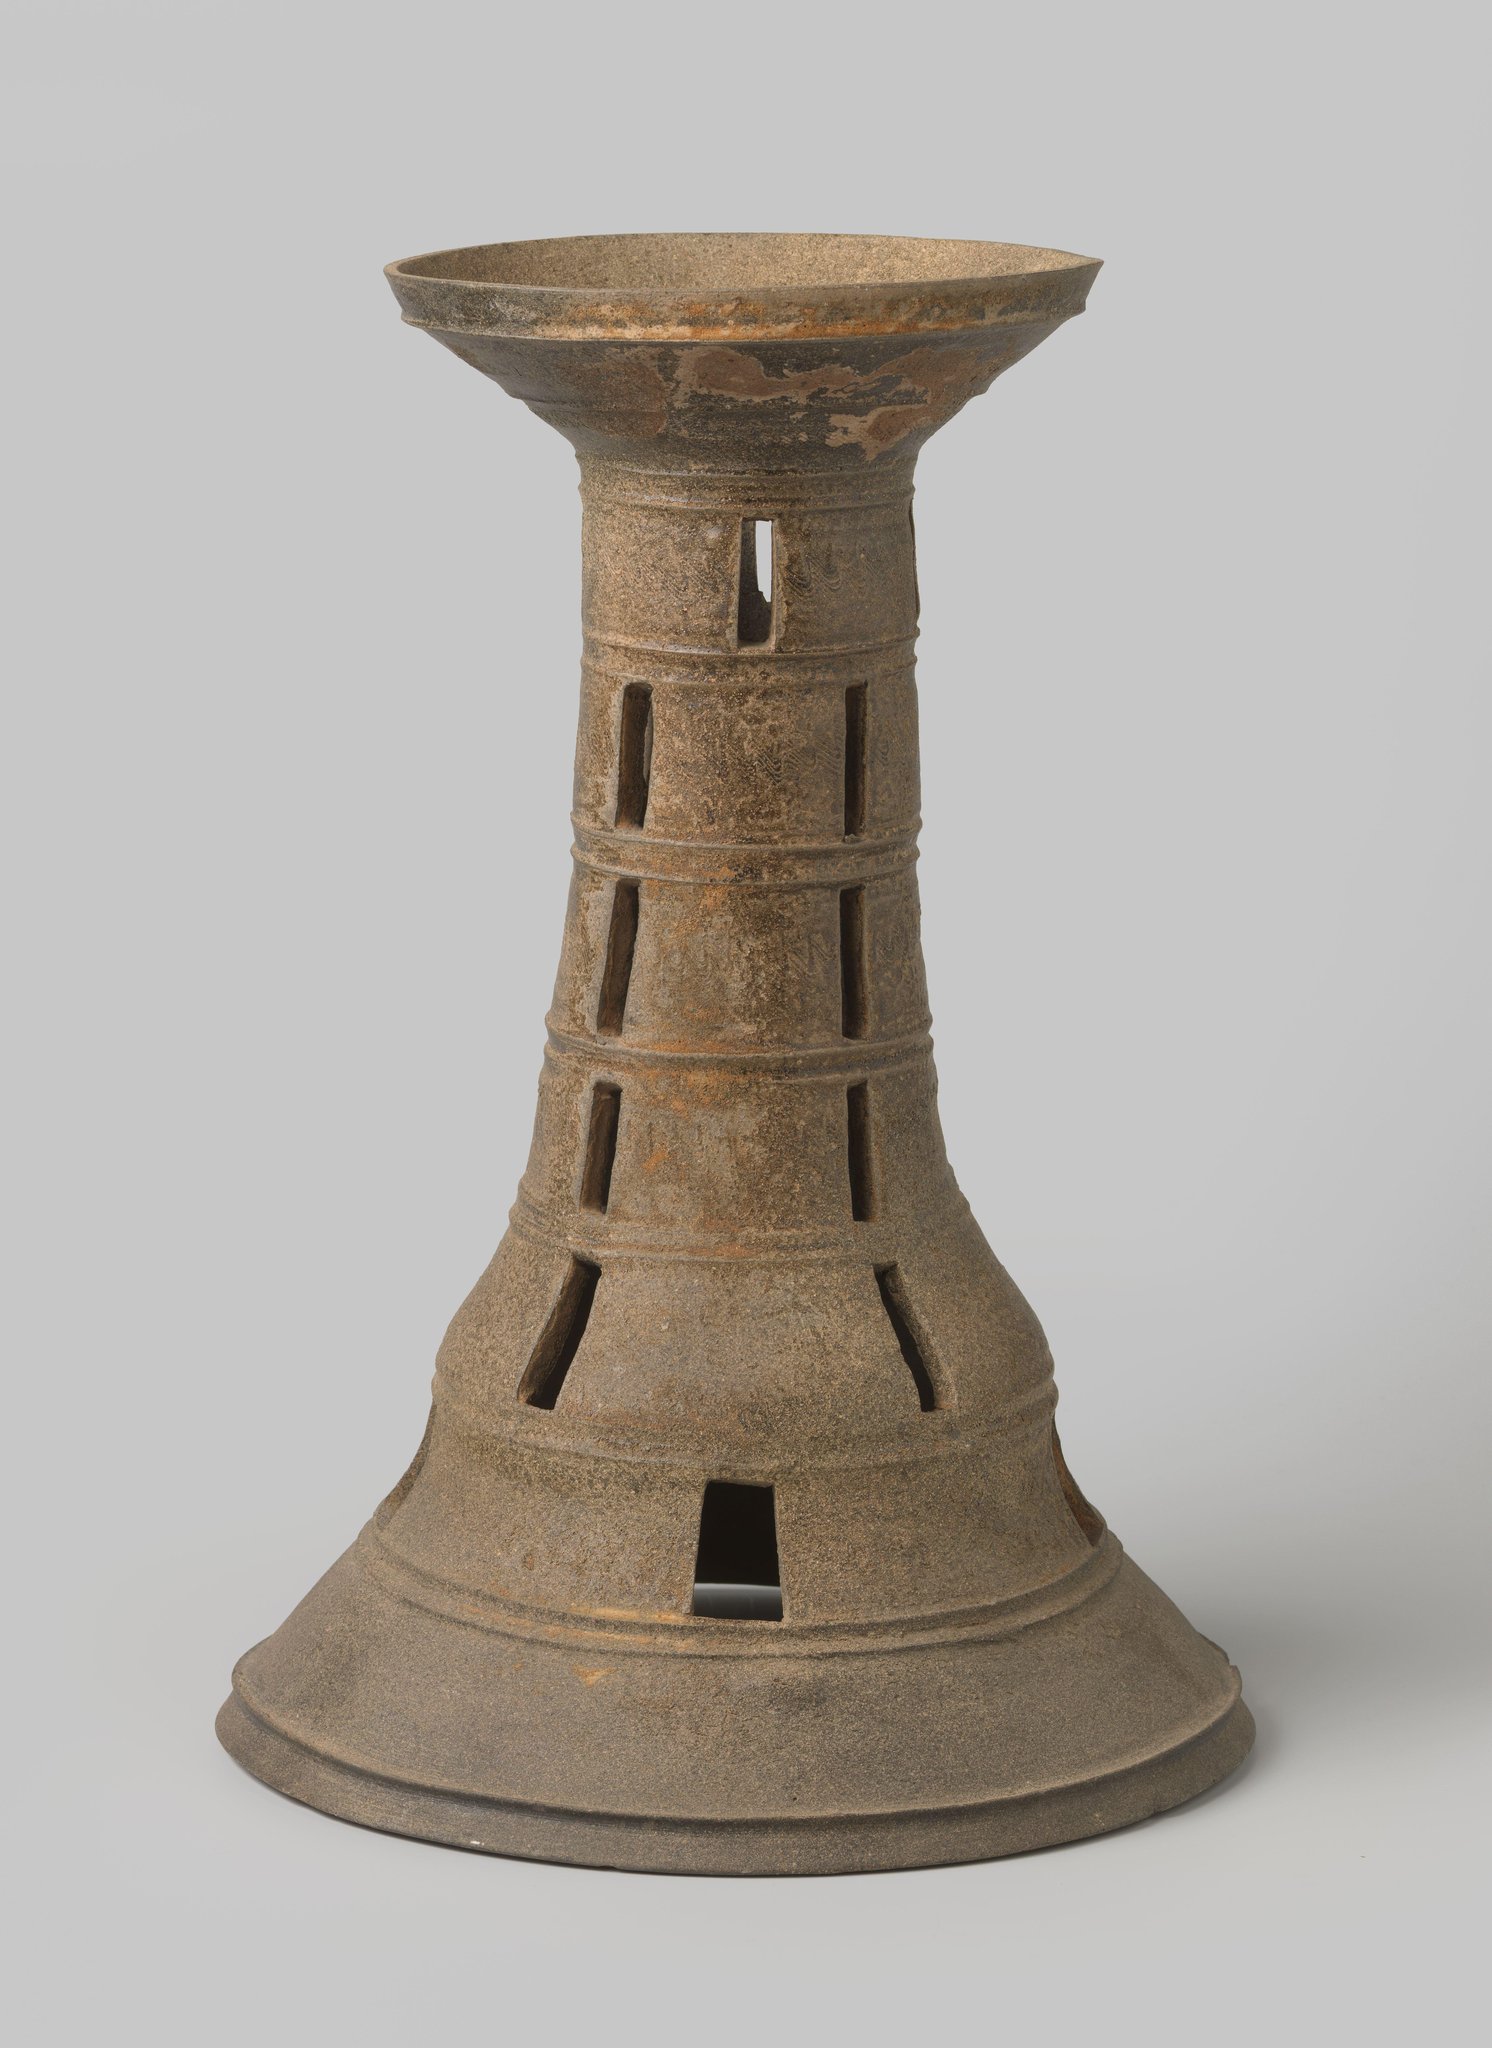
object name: stand support object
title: Standaard, grijs/groen cilinder-vormig voor pot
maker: Anonymous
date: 400-600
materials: glaze, stoneware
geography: korea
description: Stand for pot Korea 5th - 6th century Stoneware, ash glaze The pot for which this stand was intended was probably used to offer food to the gods orto the user's ancestors. Angular incisions are typical of this period.